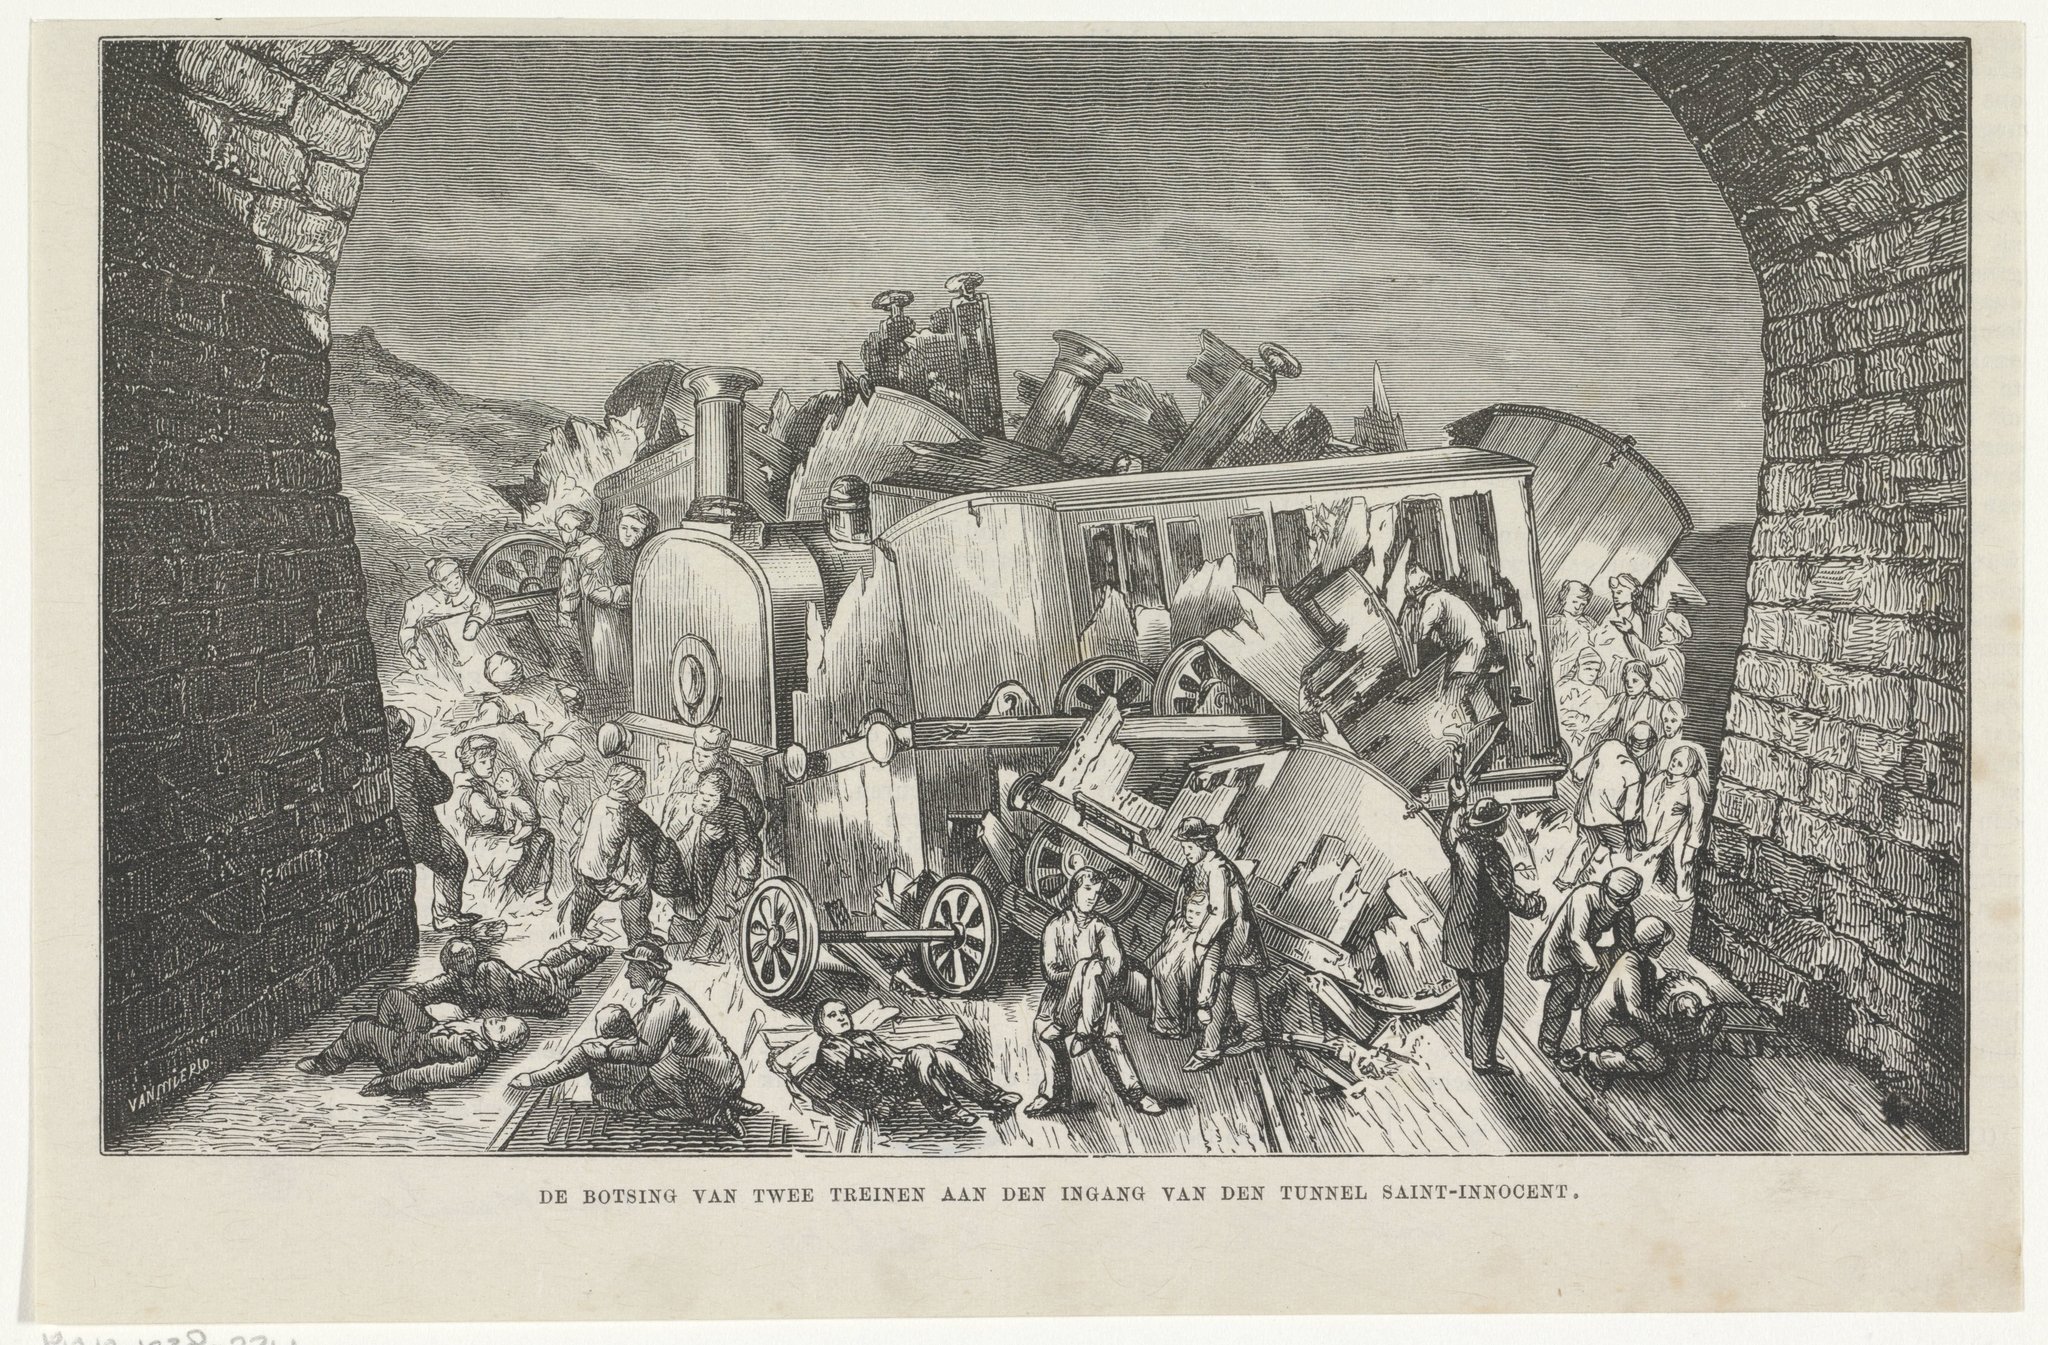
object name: book illustration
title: De botsing van twee treinen aan den ingang van den tunnel Saint-Innocent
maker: van mierlo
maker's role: print maker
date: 1876-1877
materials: paper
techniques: letterpress printing, engraving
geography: netherlands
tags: railway-accident, underground road, tunnel, france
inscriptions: collector's mark: Lugt 2228, collector's mark: Lugt 2760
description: Voor de ingang van de tunnel Saint-Innocent te Frankrijk liggen de wrakstukken van twee gebotste treinen en worden lichamen van gewonde personen in veiligheid gebracht.